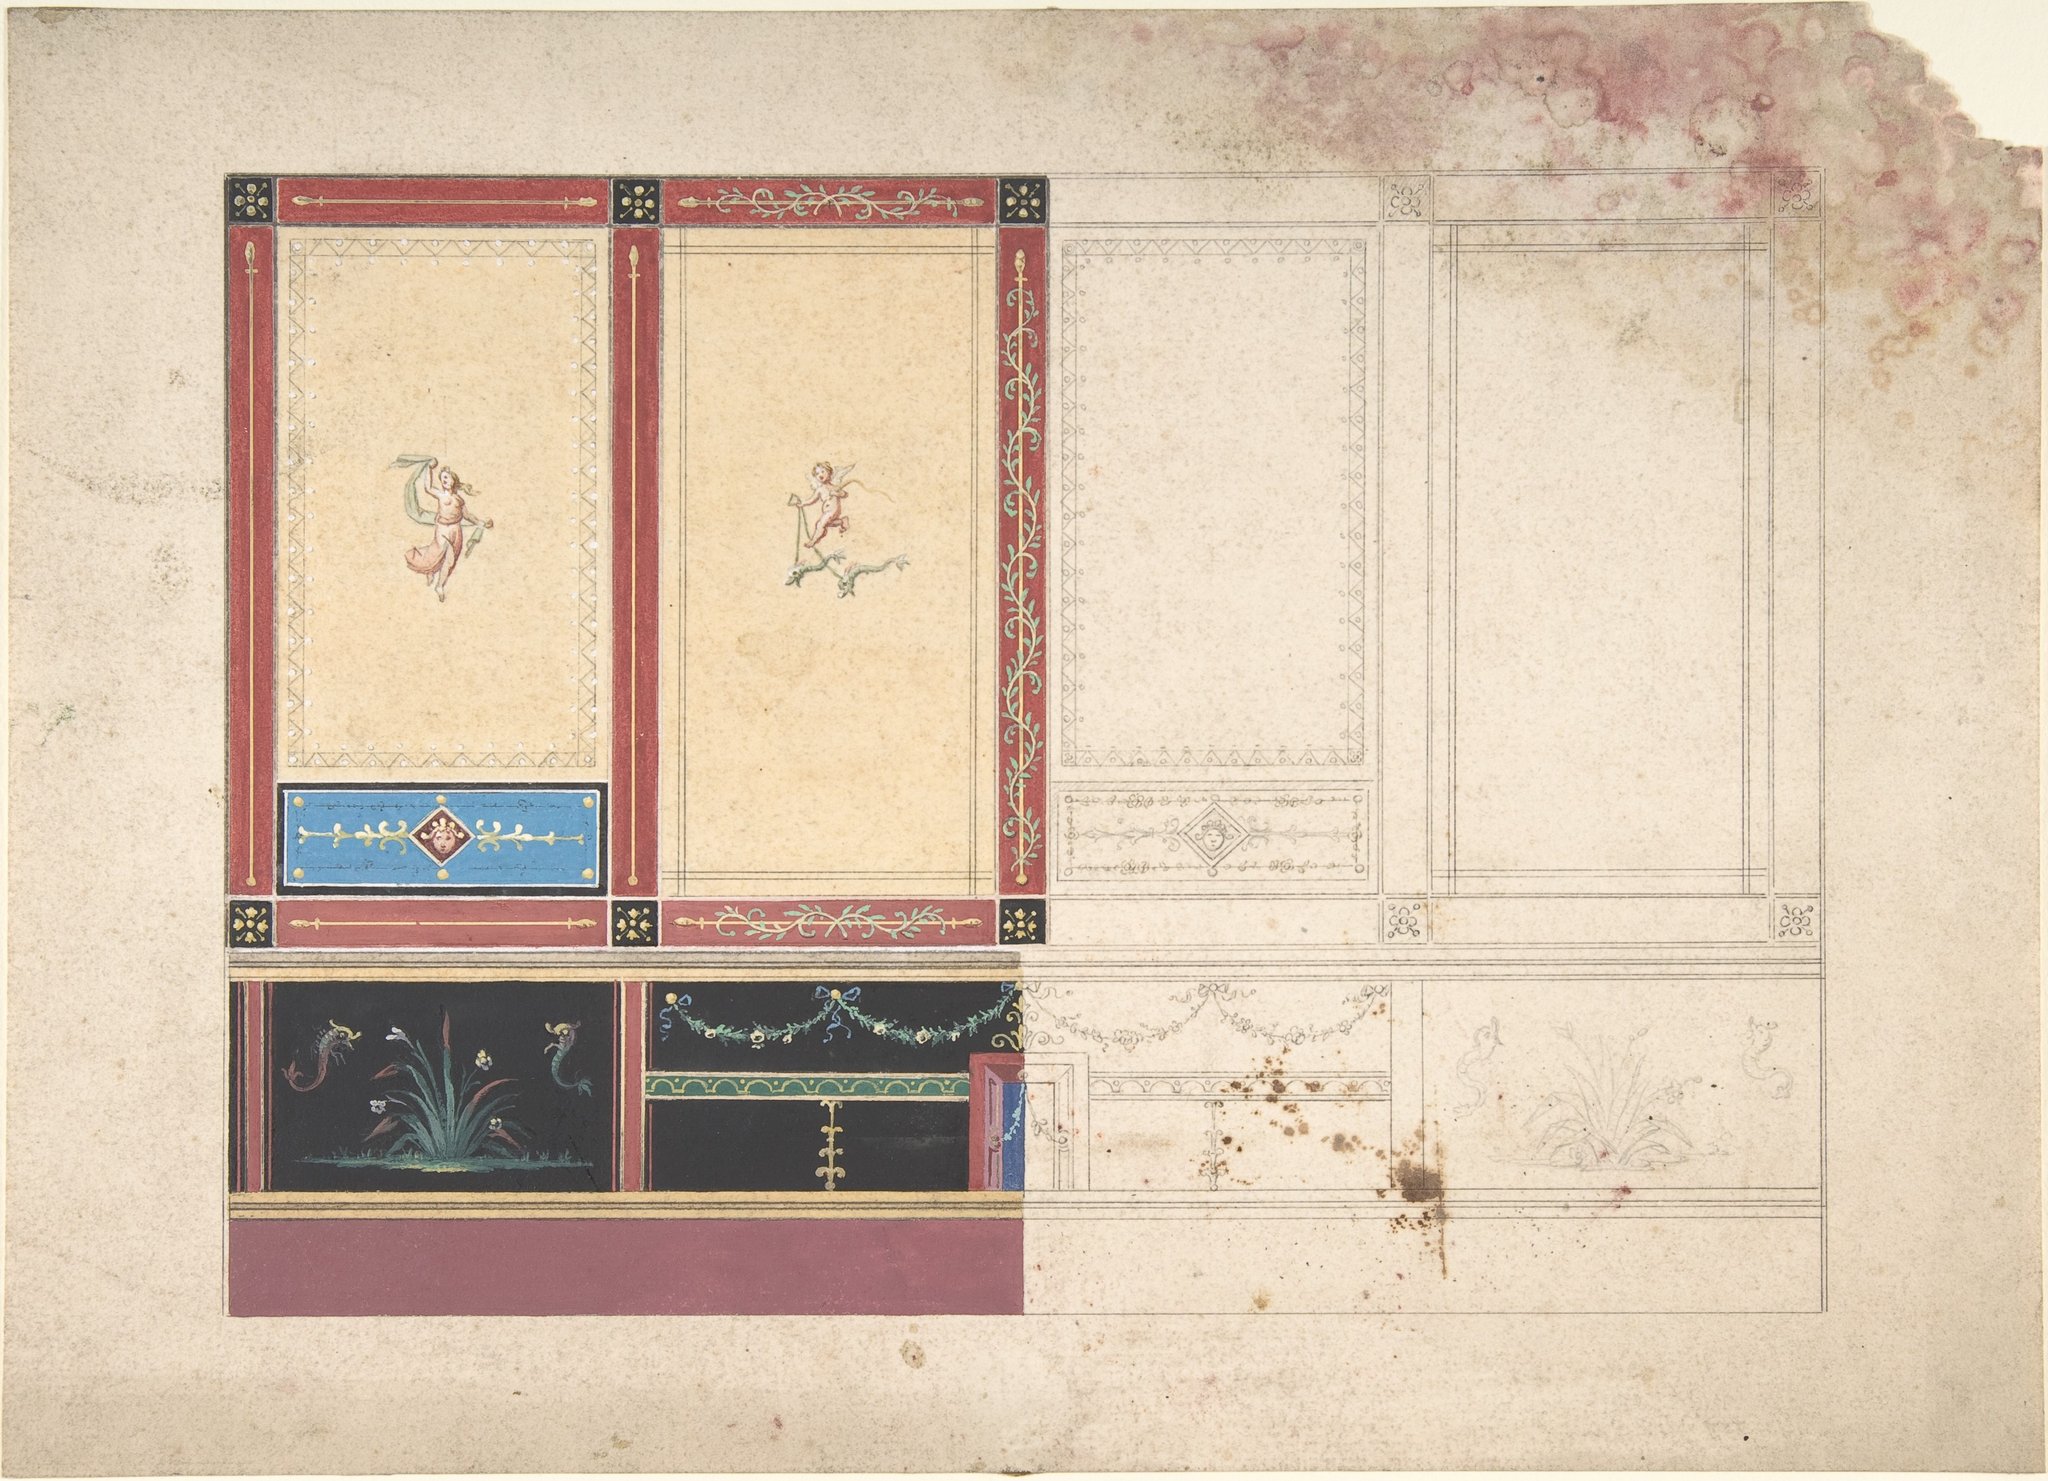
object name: drawing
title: Design for a Painted Ceiling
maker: anonymous, italian, 19th century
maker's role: artist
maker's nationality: italian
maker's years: 1800-1900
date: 1800-1900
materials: watercolor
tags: architecture